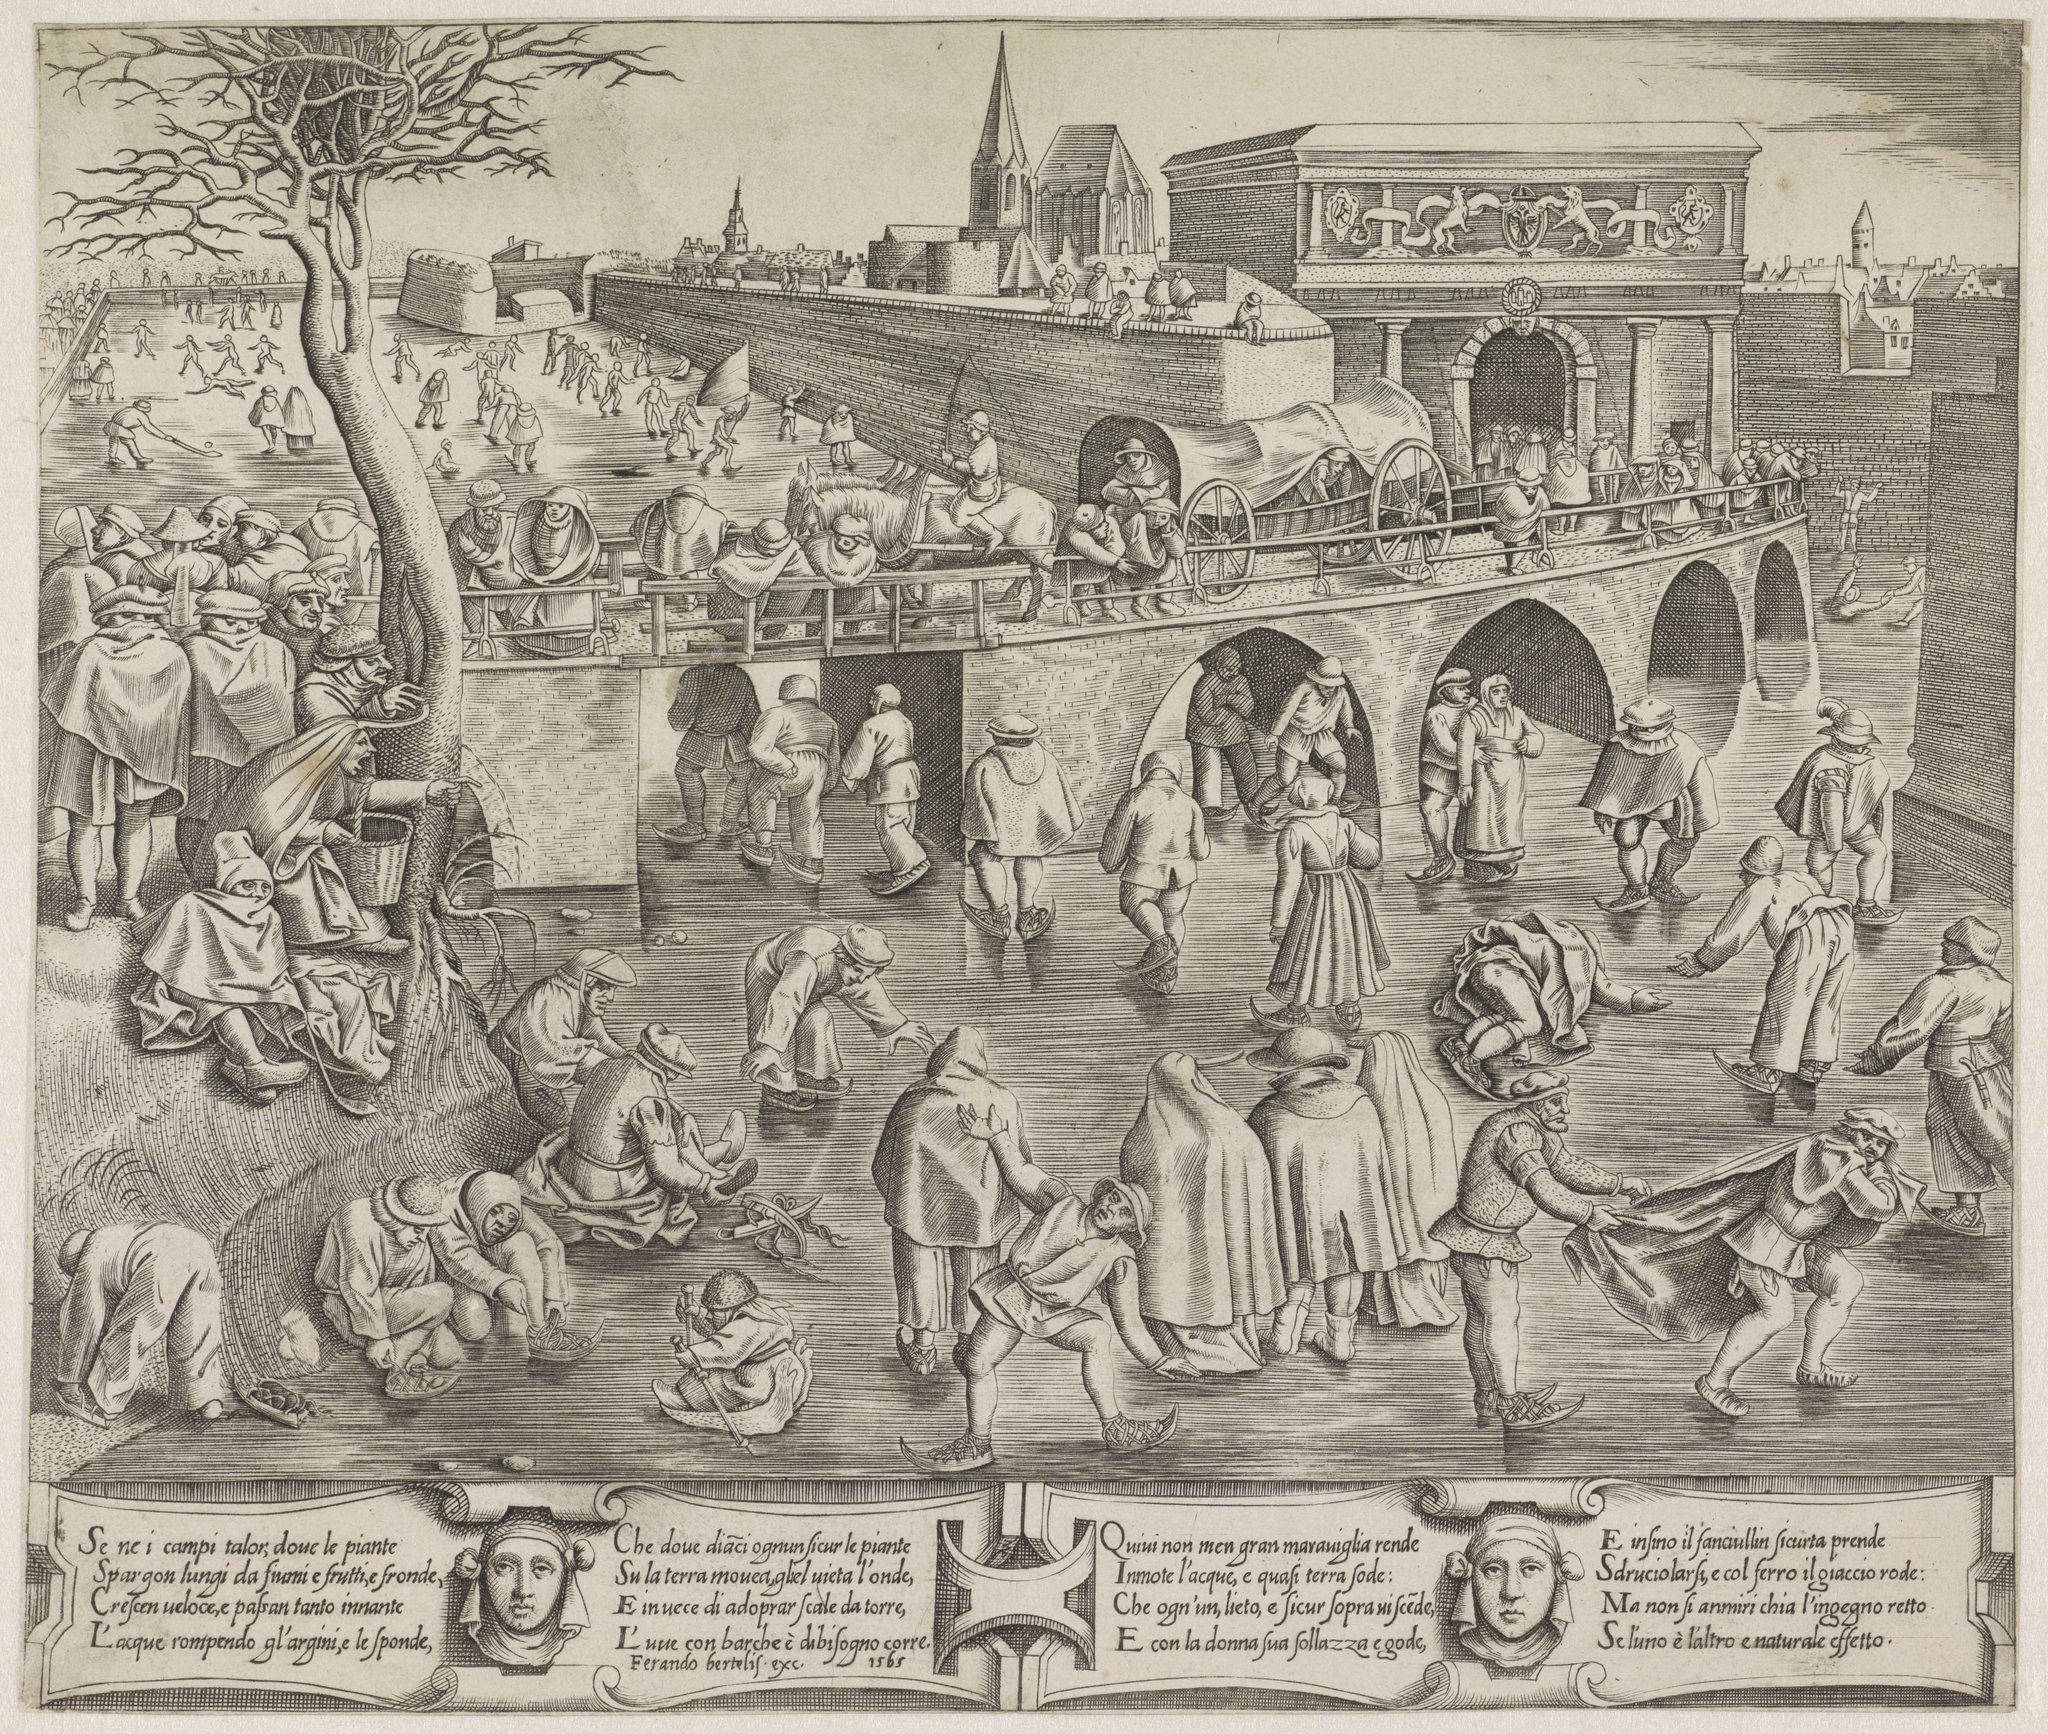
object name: print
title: Schaatsenrijders bij de Sint-Jorispoort te Antwerpen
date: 1565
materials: paper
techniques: engraving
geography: italy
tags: city-view in general; 'veduta', winter sports, skates (winter sports)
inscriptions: caption: ‘Se ne i campo...e naturale effetto.’, date: ‘1565’, address: ‘Ferando berteli exc.’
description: IJsvermaak en schaatsers op het water rond de stad Antwerpen bij de Sint-Jorispoort. Rechts is iemand op het ijs gevallen. Links op de voorgrond een kind op een prikslee.